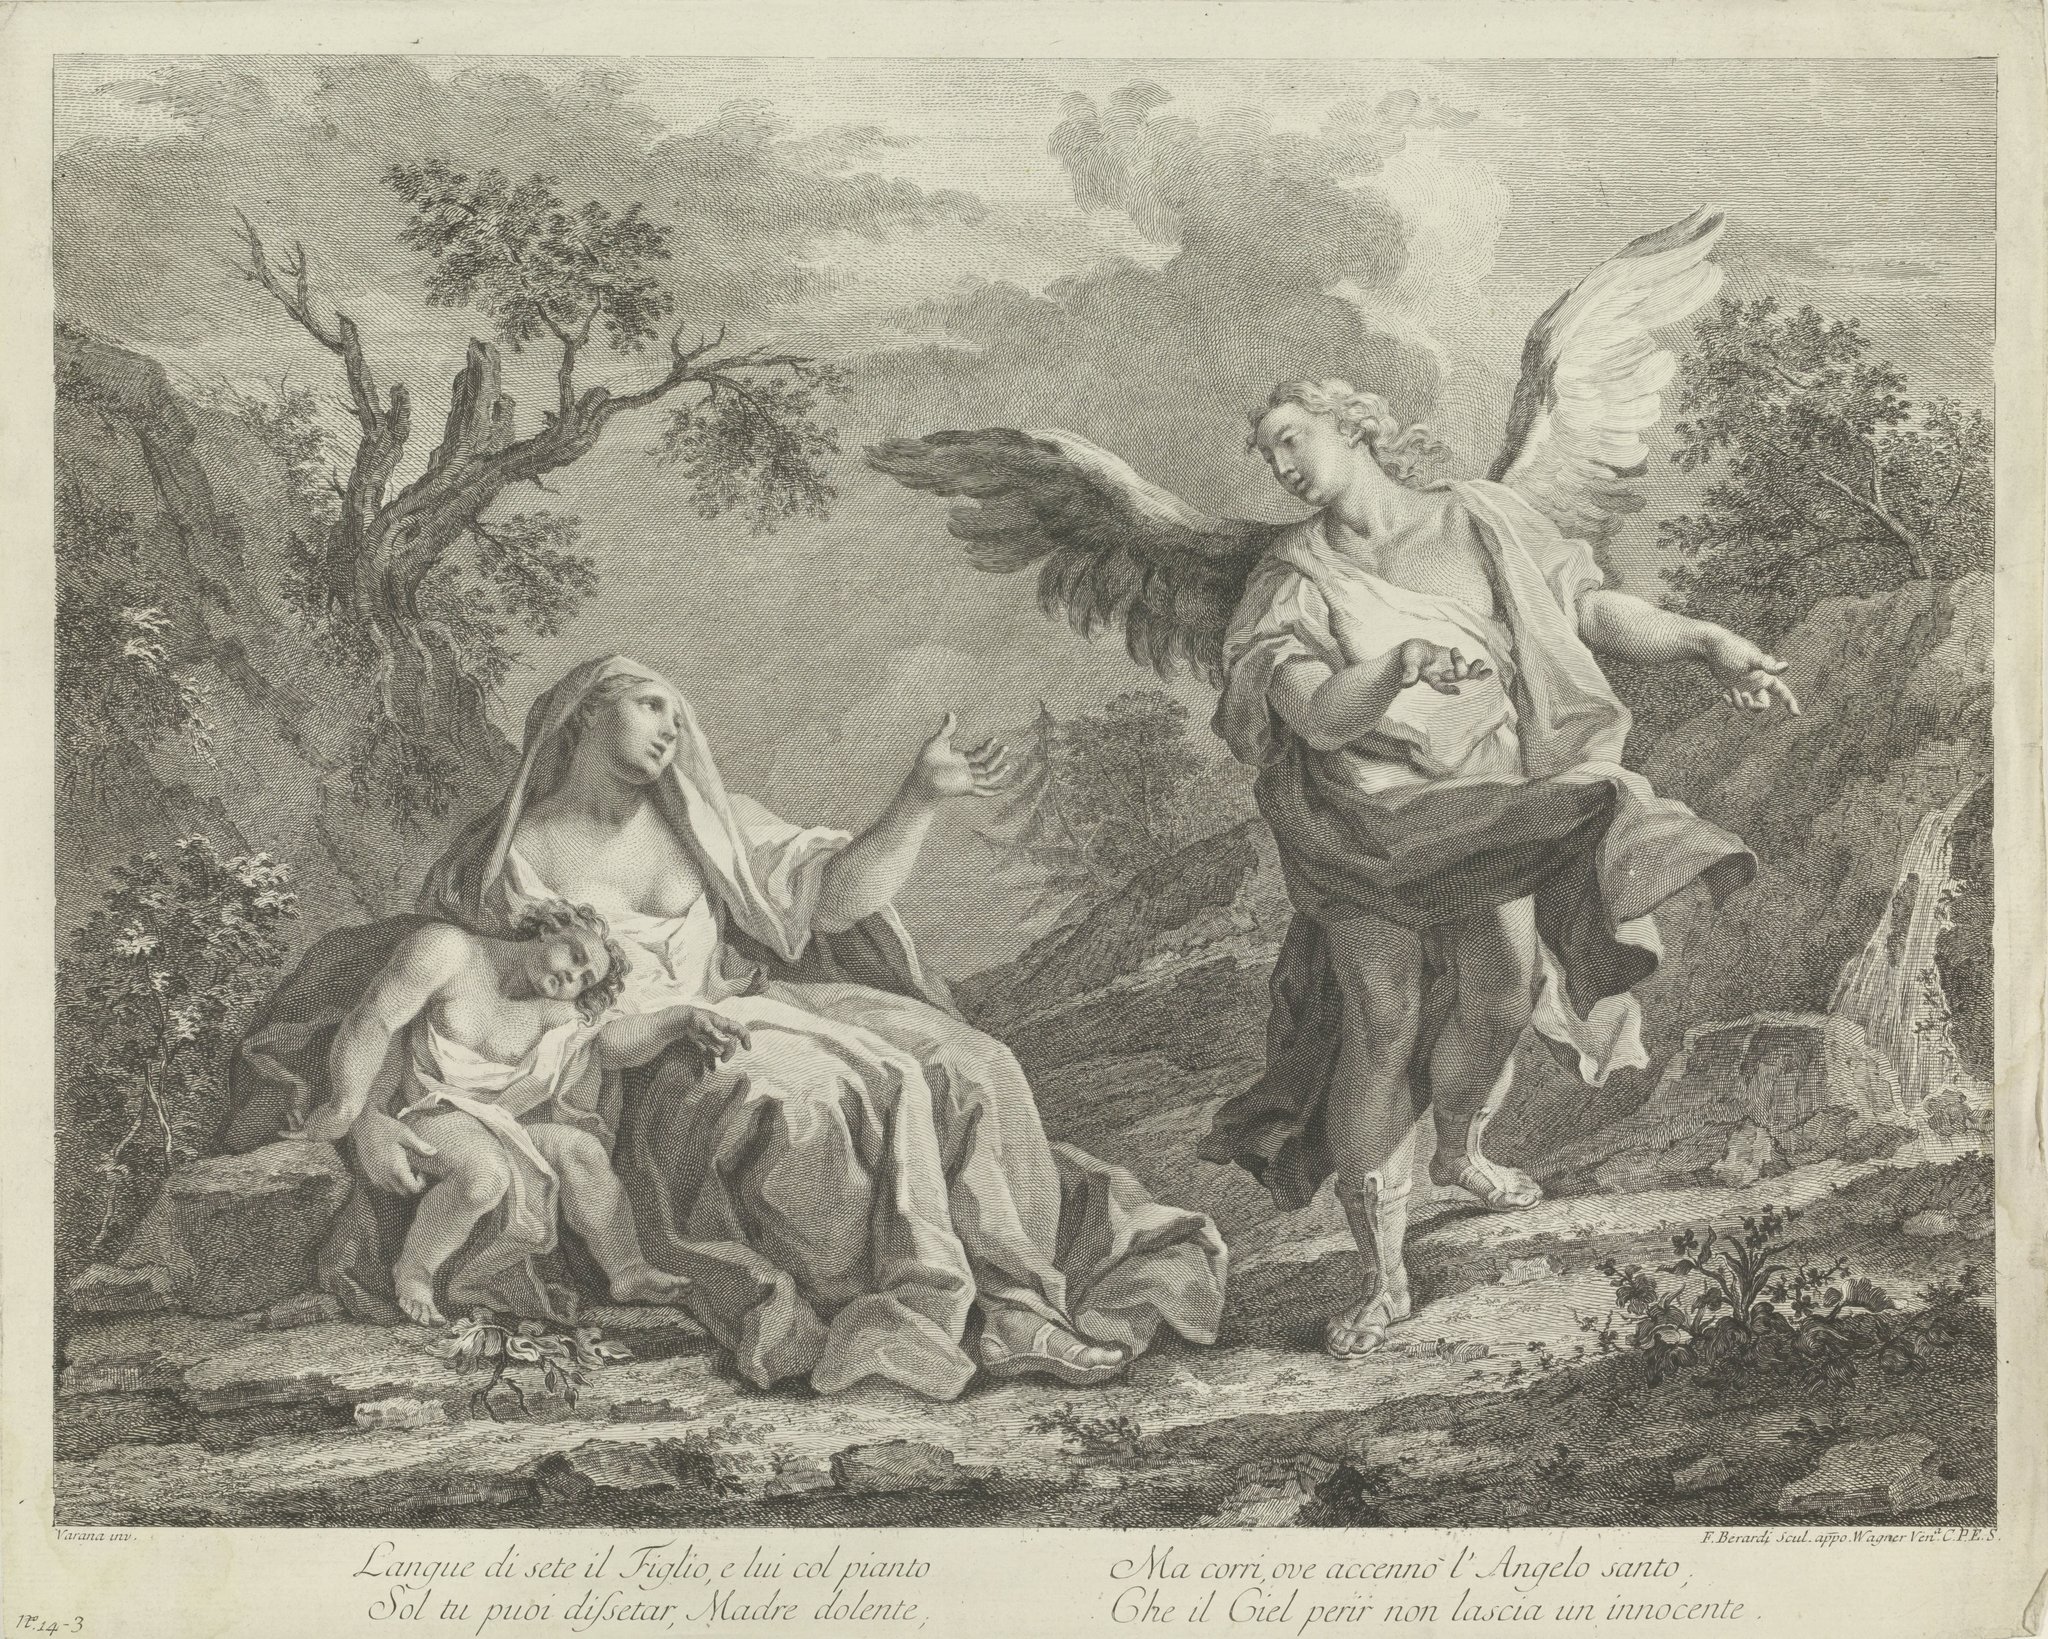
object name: print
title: Hagar en Ismaël in de woestijn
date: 1738-1767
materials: paper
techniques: engraving, etching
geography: italy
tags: the banishment of hagar and ishmael (genesis 21:9-21)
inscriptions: collector's mark: Lugt 2233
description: Hagar en Ismaël zitten in de woestijn. Rechts verschijnt de aartsengel Michaël die moeder en zoon komt redden. Italiaans vers in ondermarge. Genummerd linksonder: No. 14-3.